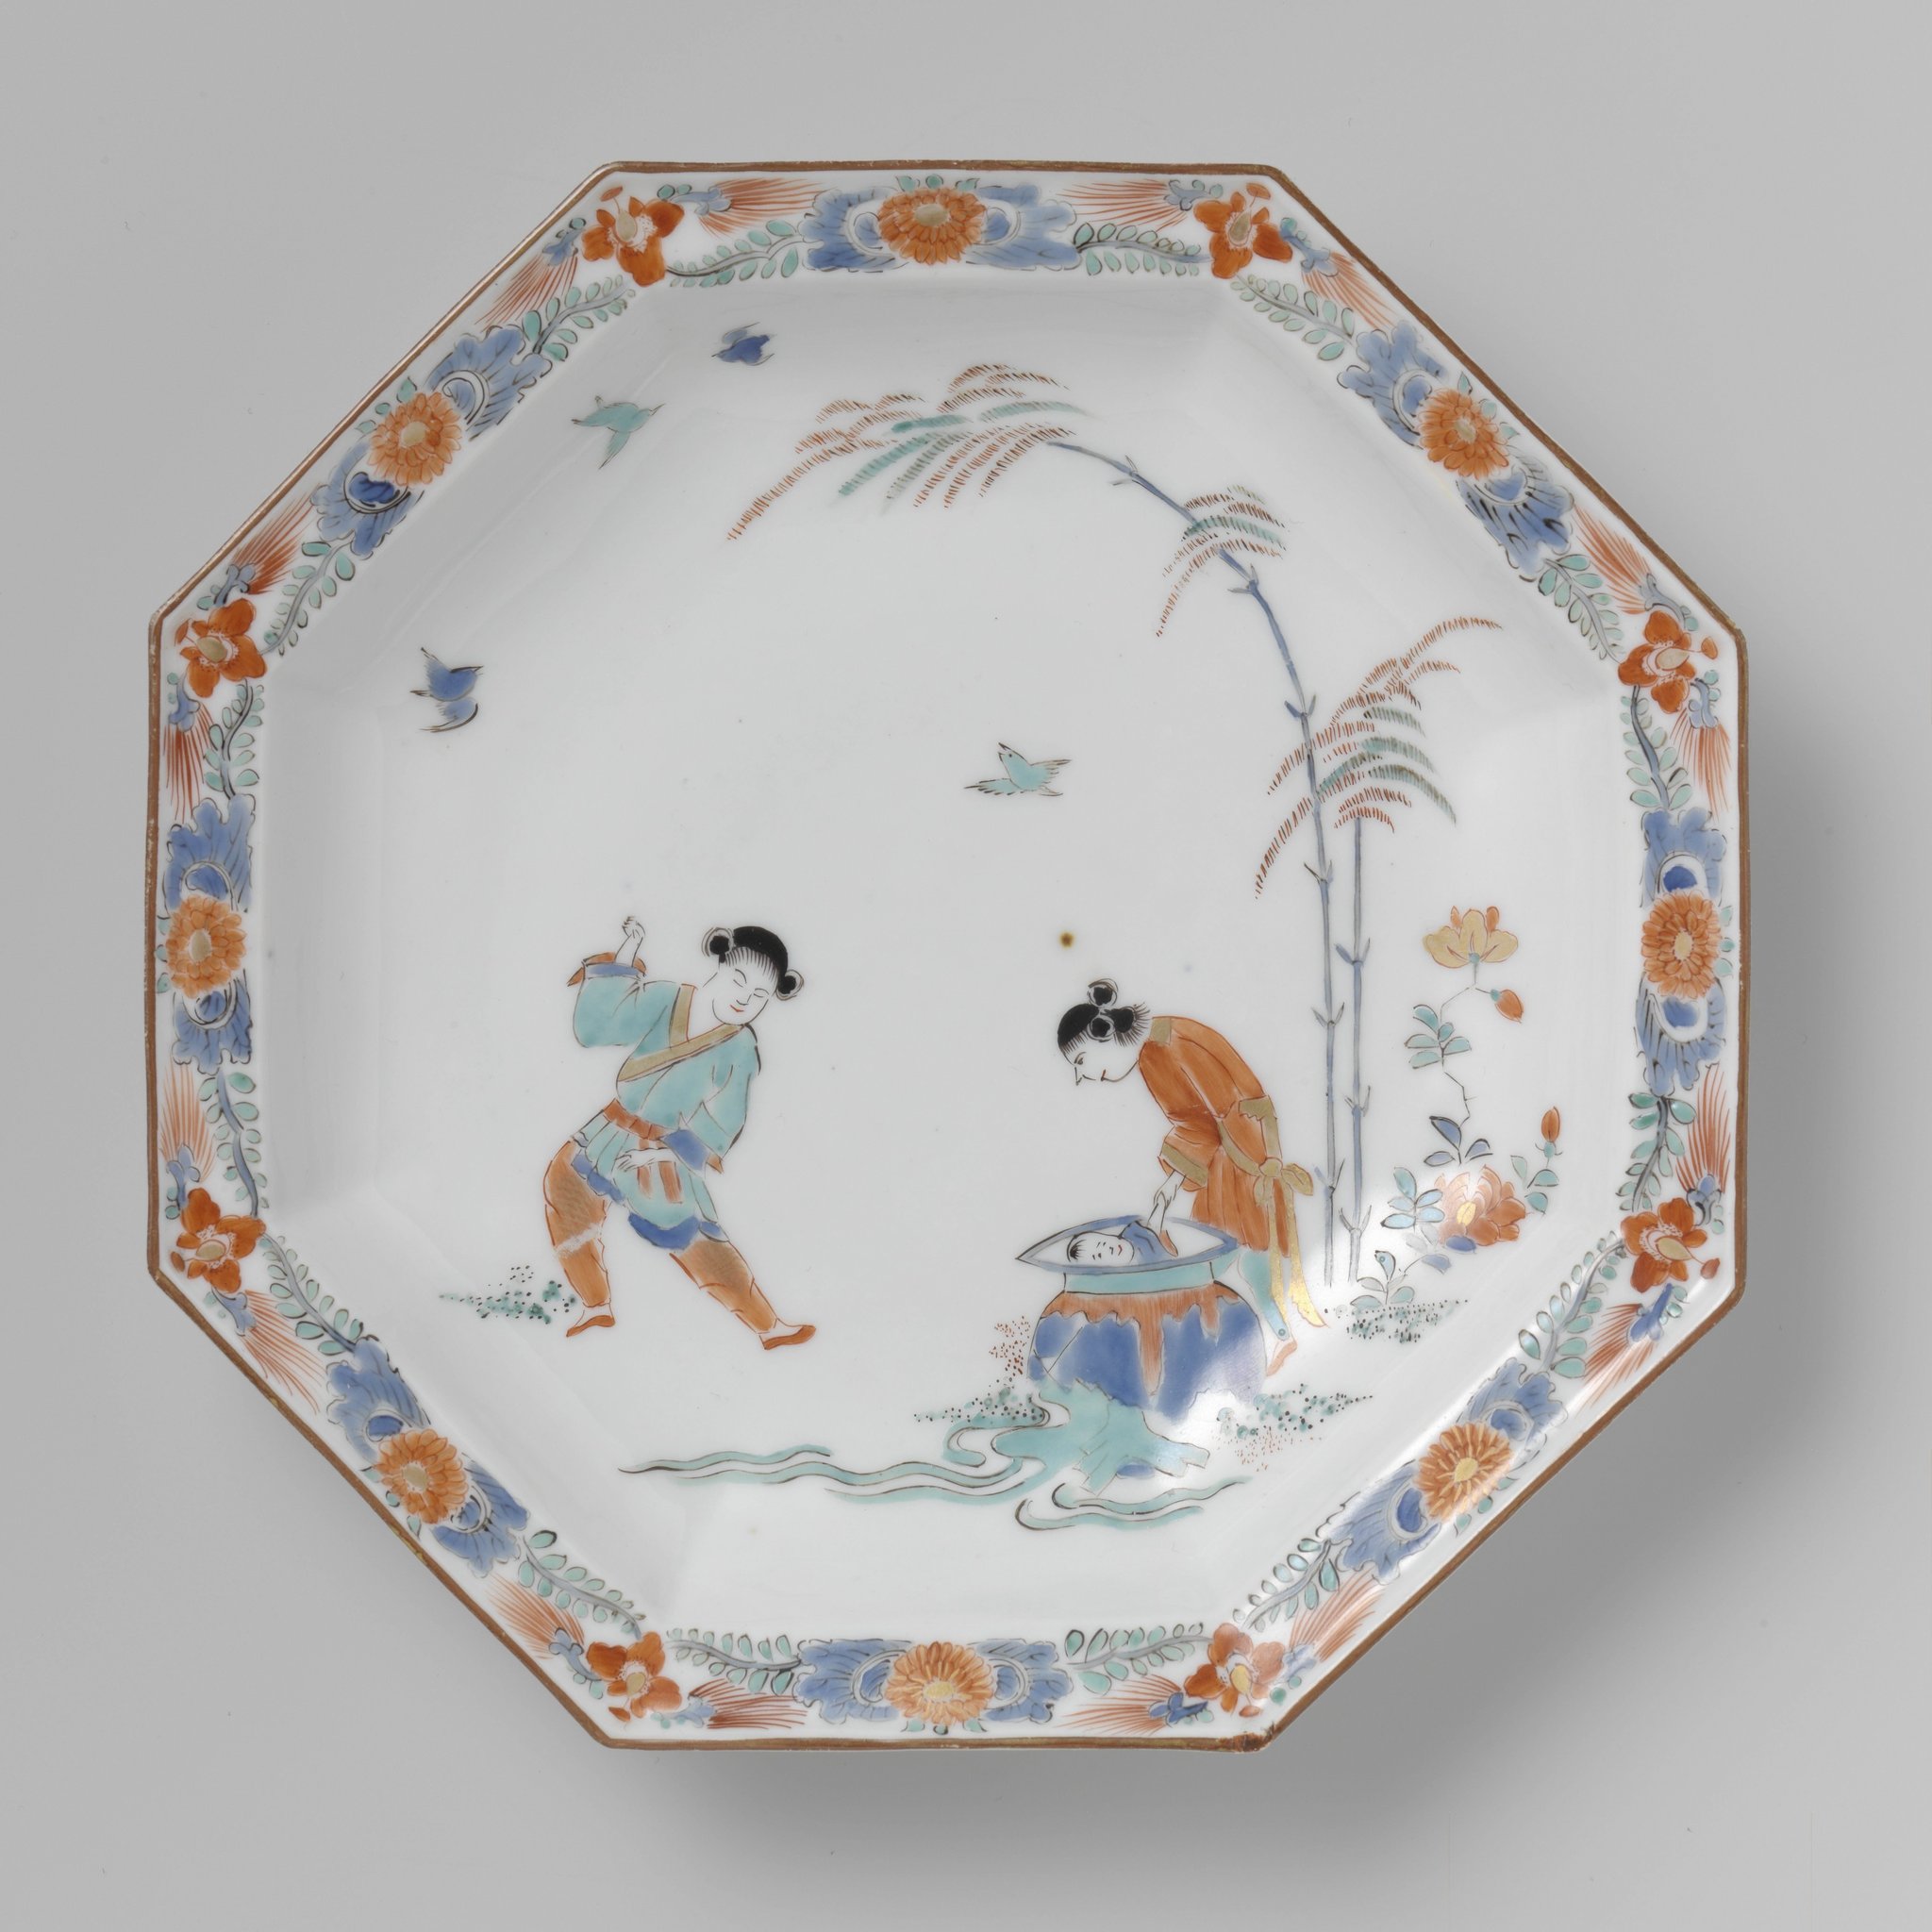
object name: dish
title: Schaal, achthoekig, veelkleurig beschilderd met een Kakiemon-decor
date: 1730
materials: porcelain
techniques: painted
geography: meissen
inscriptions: factory mark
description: Schaal van beschilderd porselein. De schaal heeft een achthoekige rand en is beschilderd met het Shiba Onkô-motief. De schaal is gemerkt.